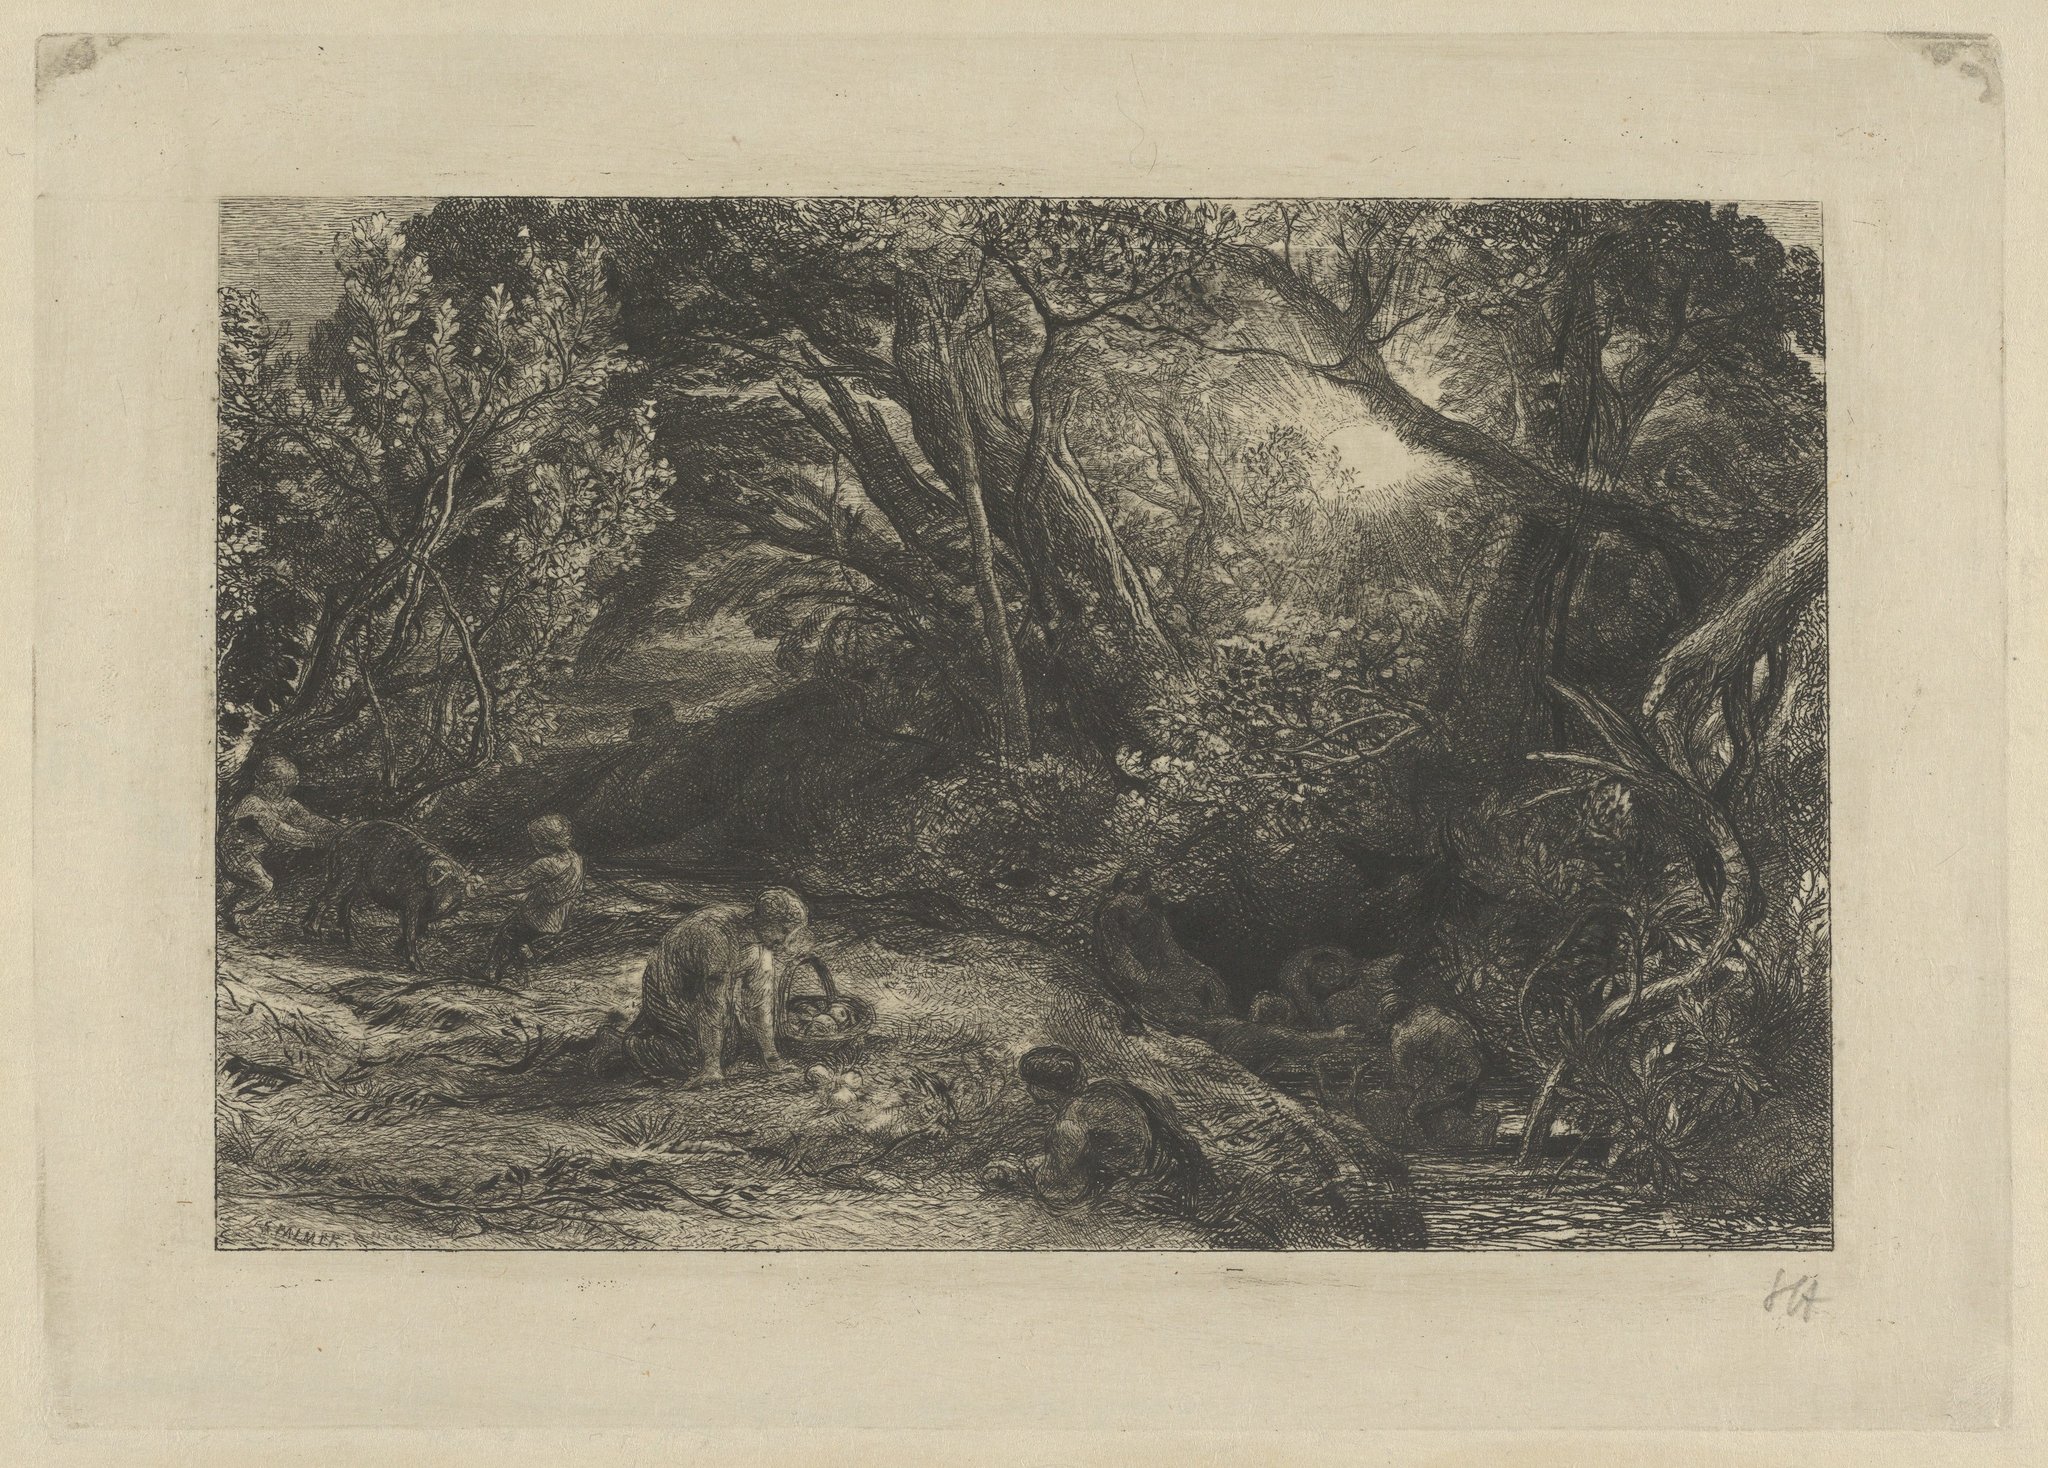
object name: print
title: The Morning of Life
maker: samuel palmer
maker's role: artist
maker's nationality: british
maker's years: 1805-1881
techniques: etching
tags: human figures,animals,trees,morning,working